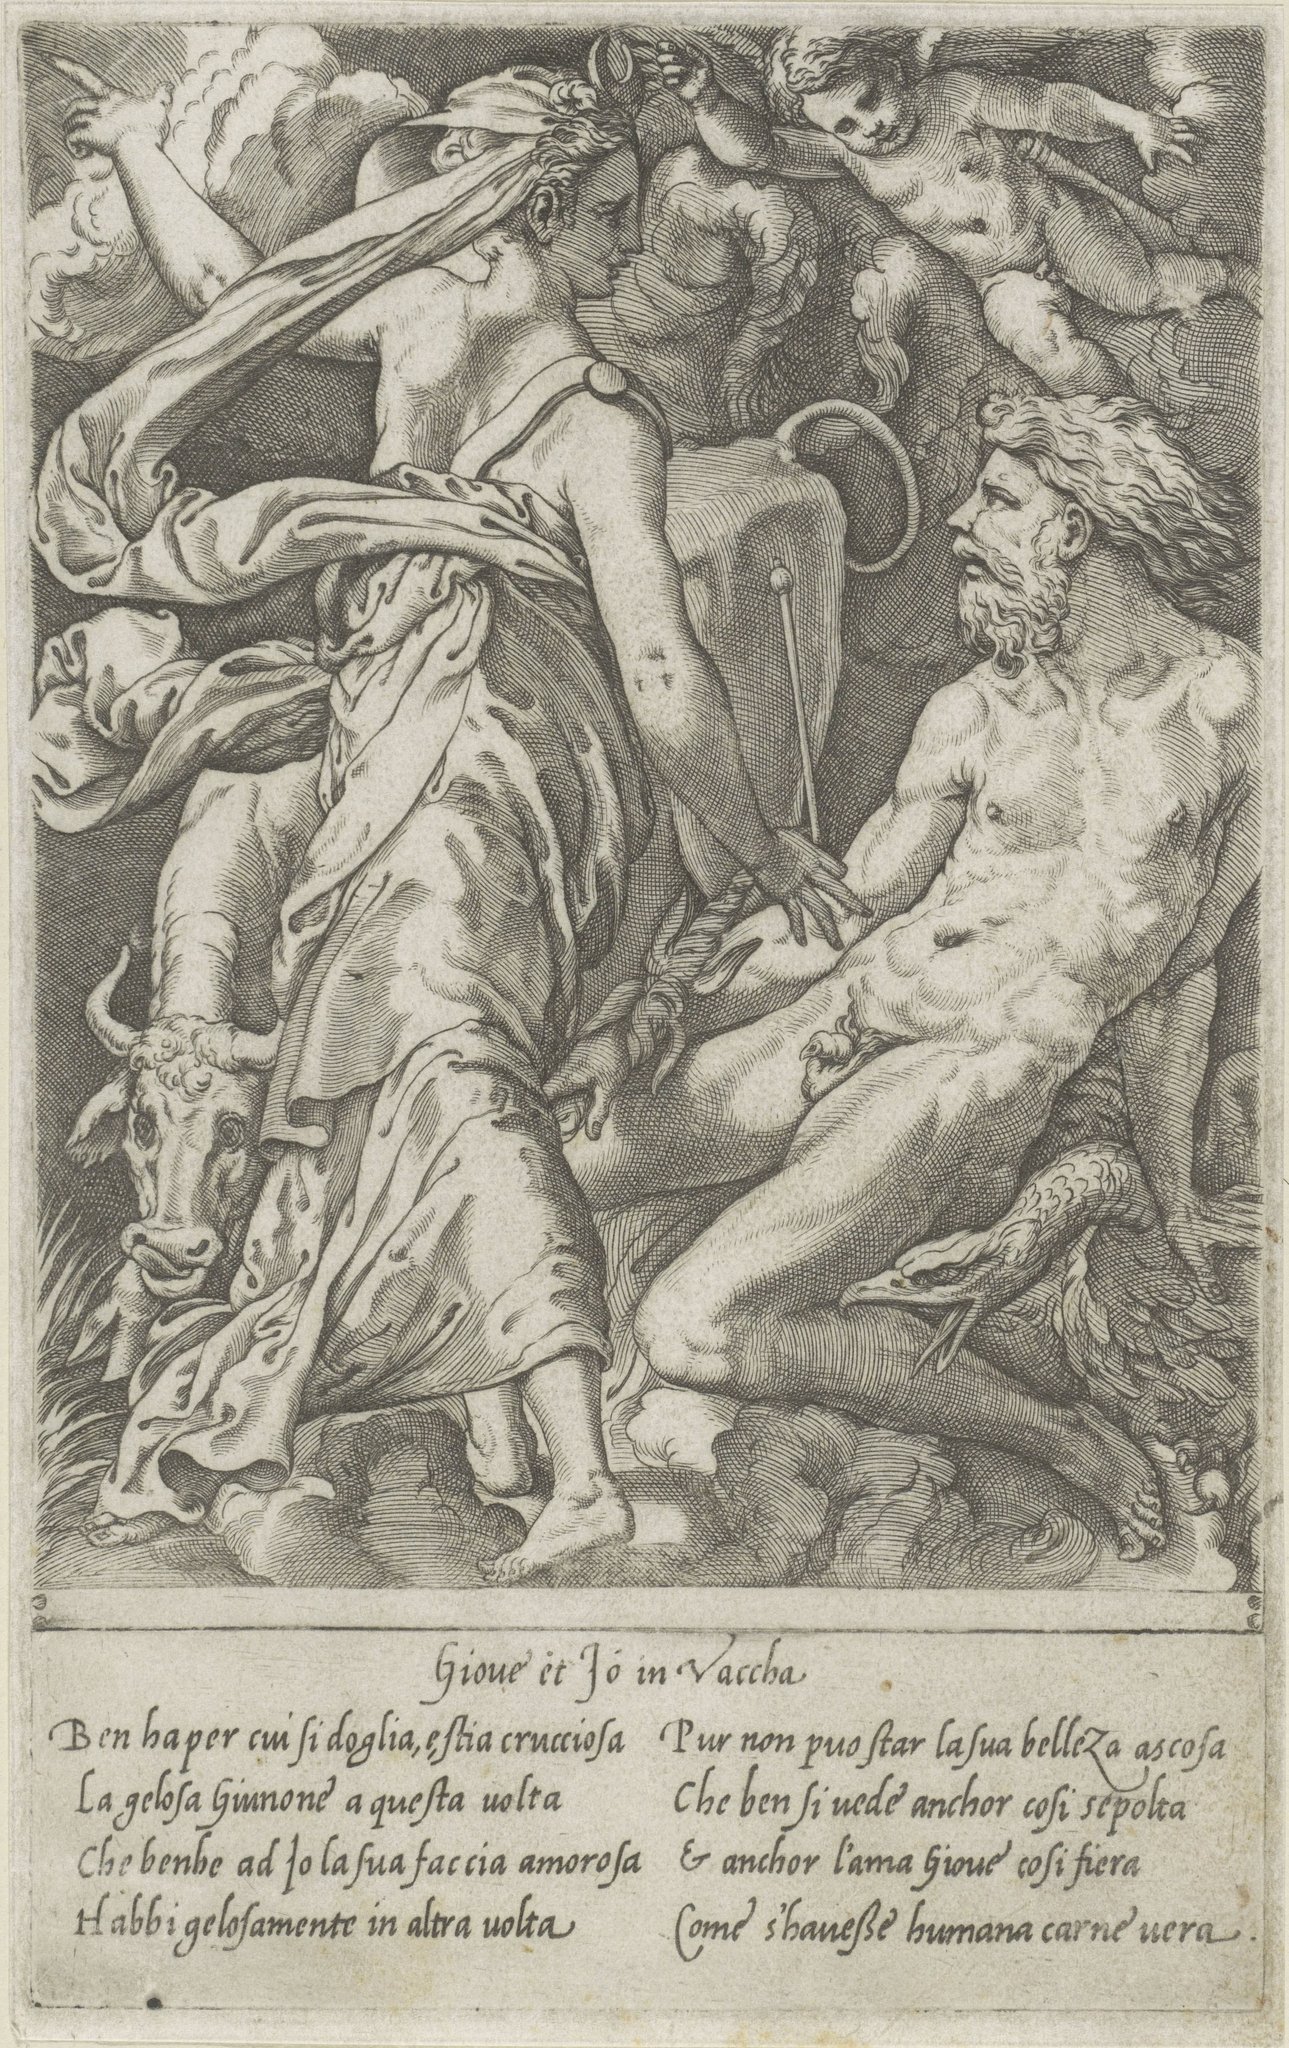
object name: print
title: Loves of the Gods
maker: giovanni jacopo caraglio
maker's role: goldsmith, print maker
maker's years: 1500-1565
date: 1515-1565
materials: paper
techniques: engraving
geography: italy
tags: io changed into a cow: to avoid detection by juno, jupiter changes io into a cow (ovid, metamorphoses i 611)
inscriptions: collector's mark: Lugt 240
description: Juno betrapt Jupiter en Io. Jupiter heeft Io in een koe veranderd. Rechtsboven een putto. In de ondermarge Italiaans vers in twee kolommen.